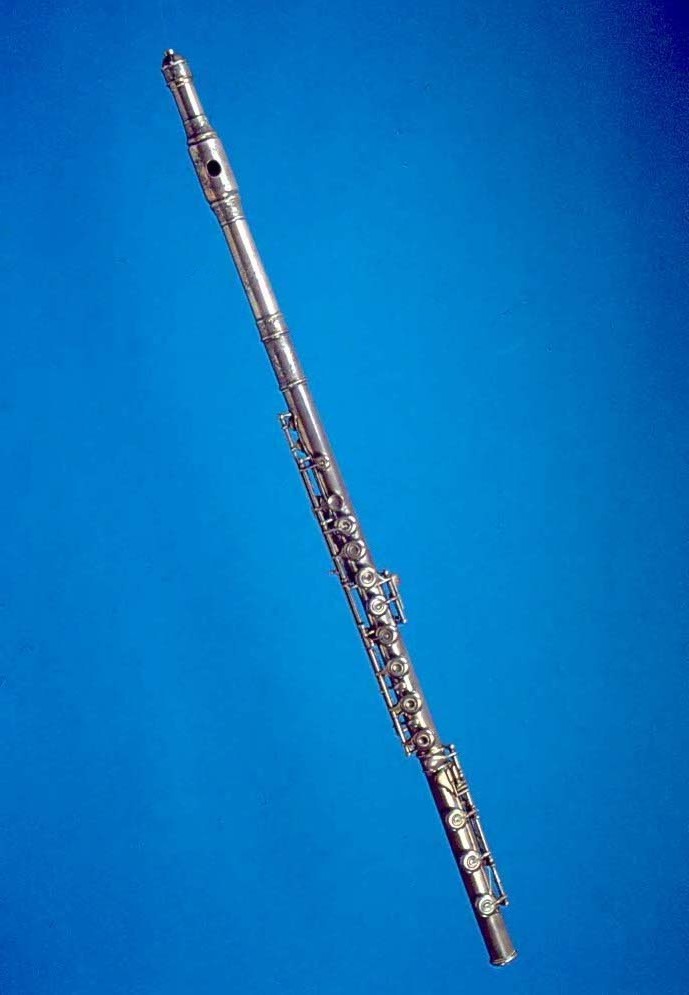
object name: flute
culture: american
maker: alfred g. badger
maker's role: maker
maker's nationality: american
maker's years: 1815-1892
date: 1860-1865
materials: silver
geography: united states